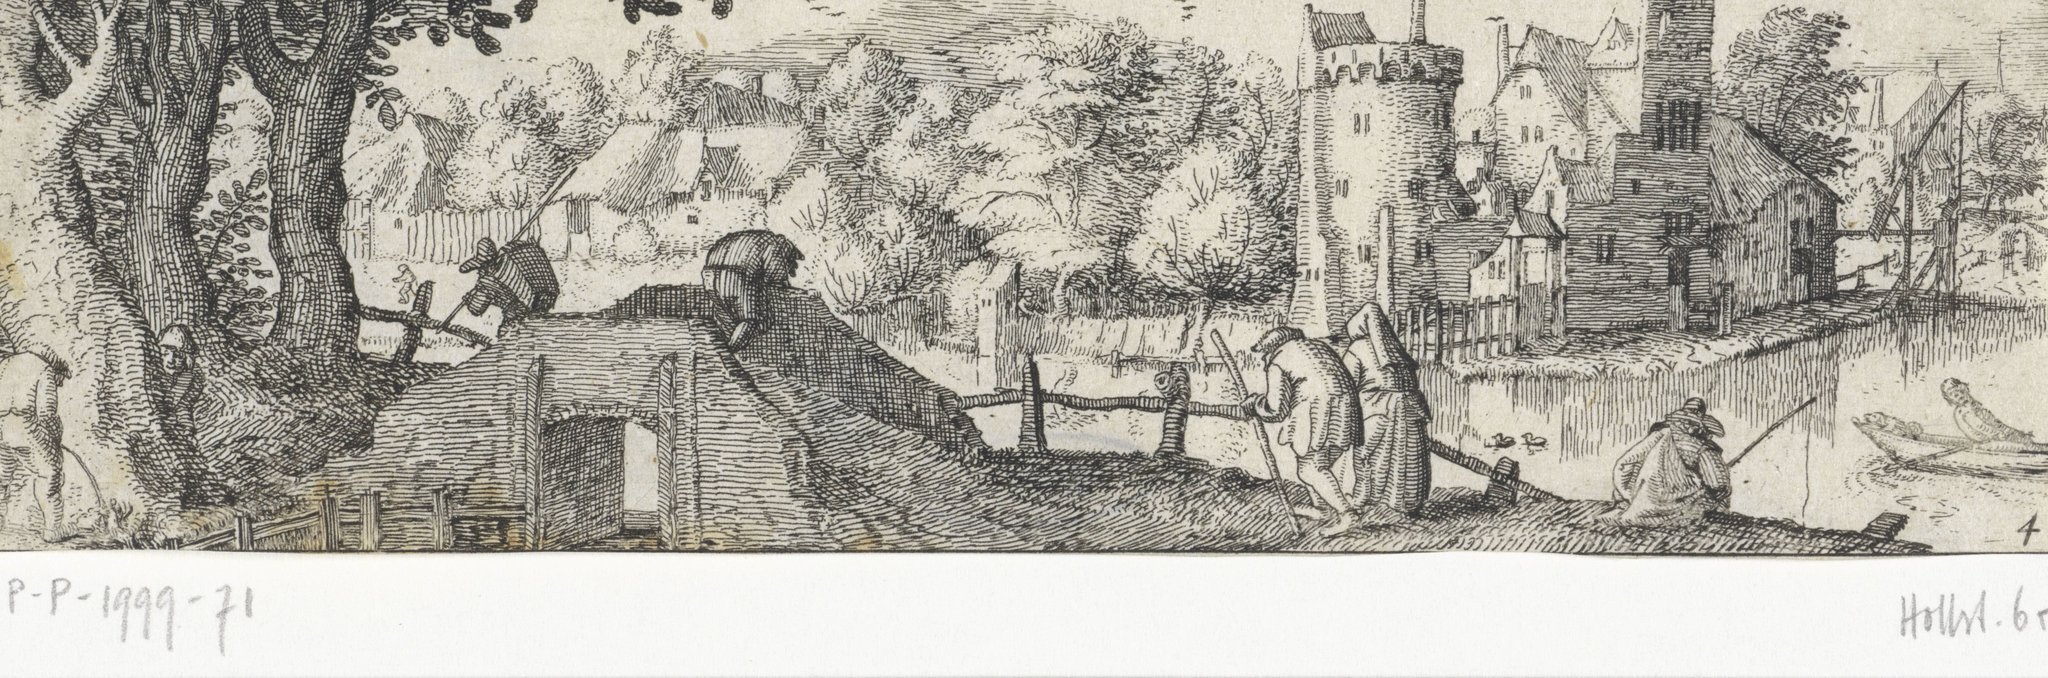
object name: print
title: Beroepen en gezichten in en rond Amsterdam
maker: claes jansz. visscher (ii)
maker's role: draughtsman, print maker, publisher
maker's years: 1586-1652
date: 1612-1652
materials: paper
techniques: etching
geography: amsterdam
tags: landscape with tower or castle, bridge, urination, fisherman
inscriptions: collector's mark: Lugt 2760, inscription: ‘4’, collector's mark: Lugt 2228, inscription: ‘99/4’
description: Gezicht op een kasteel aan het water. Op de voorgrond een visser, een lopende oude man en vrouw, en twee mannen op een bruggetje. Links staat een man te plassen tegen een boom, een vrouw kijkt van achter een boom toe. Prent uit een serie met beroepen en bezigheden van mensen en gezichten rond Amsterdam.